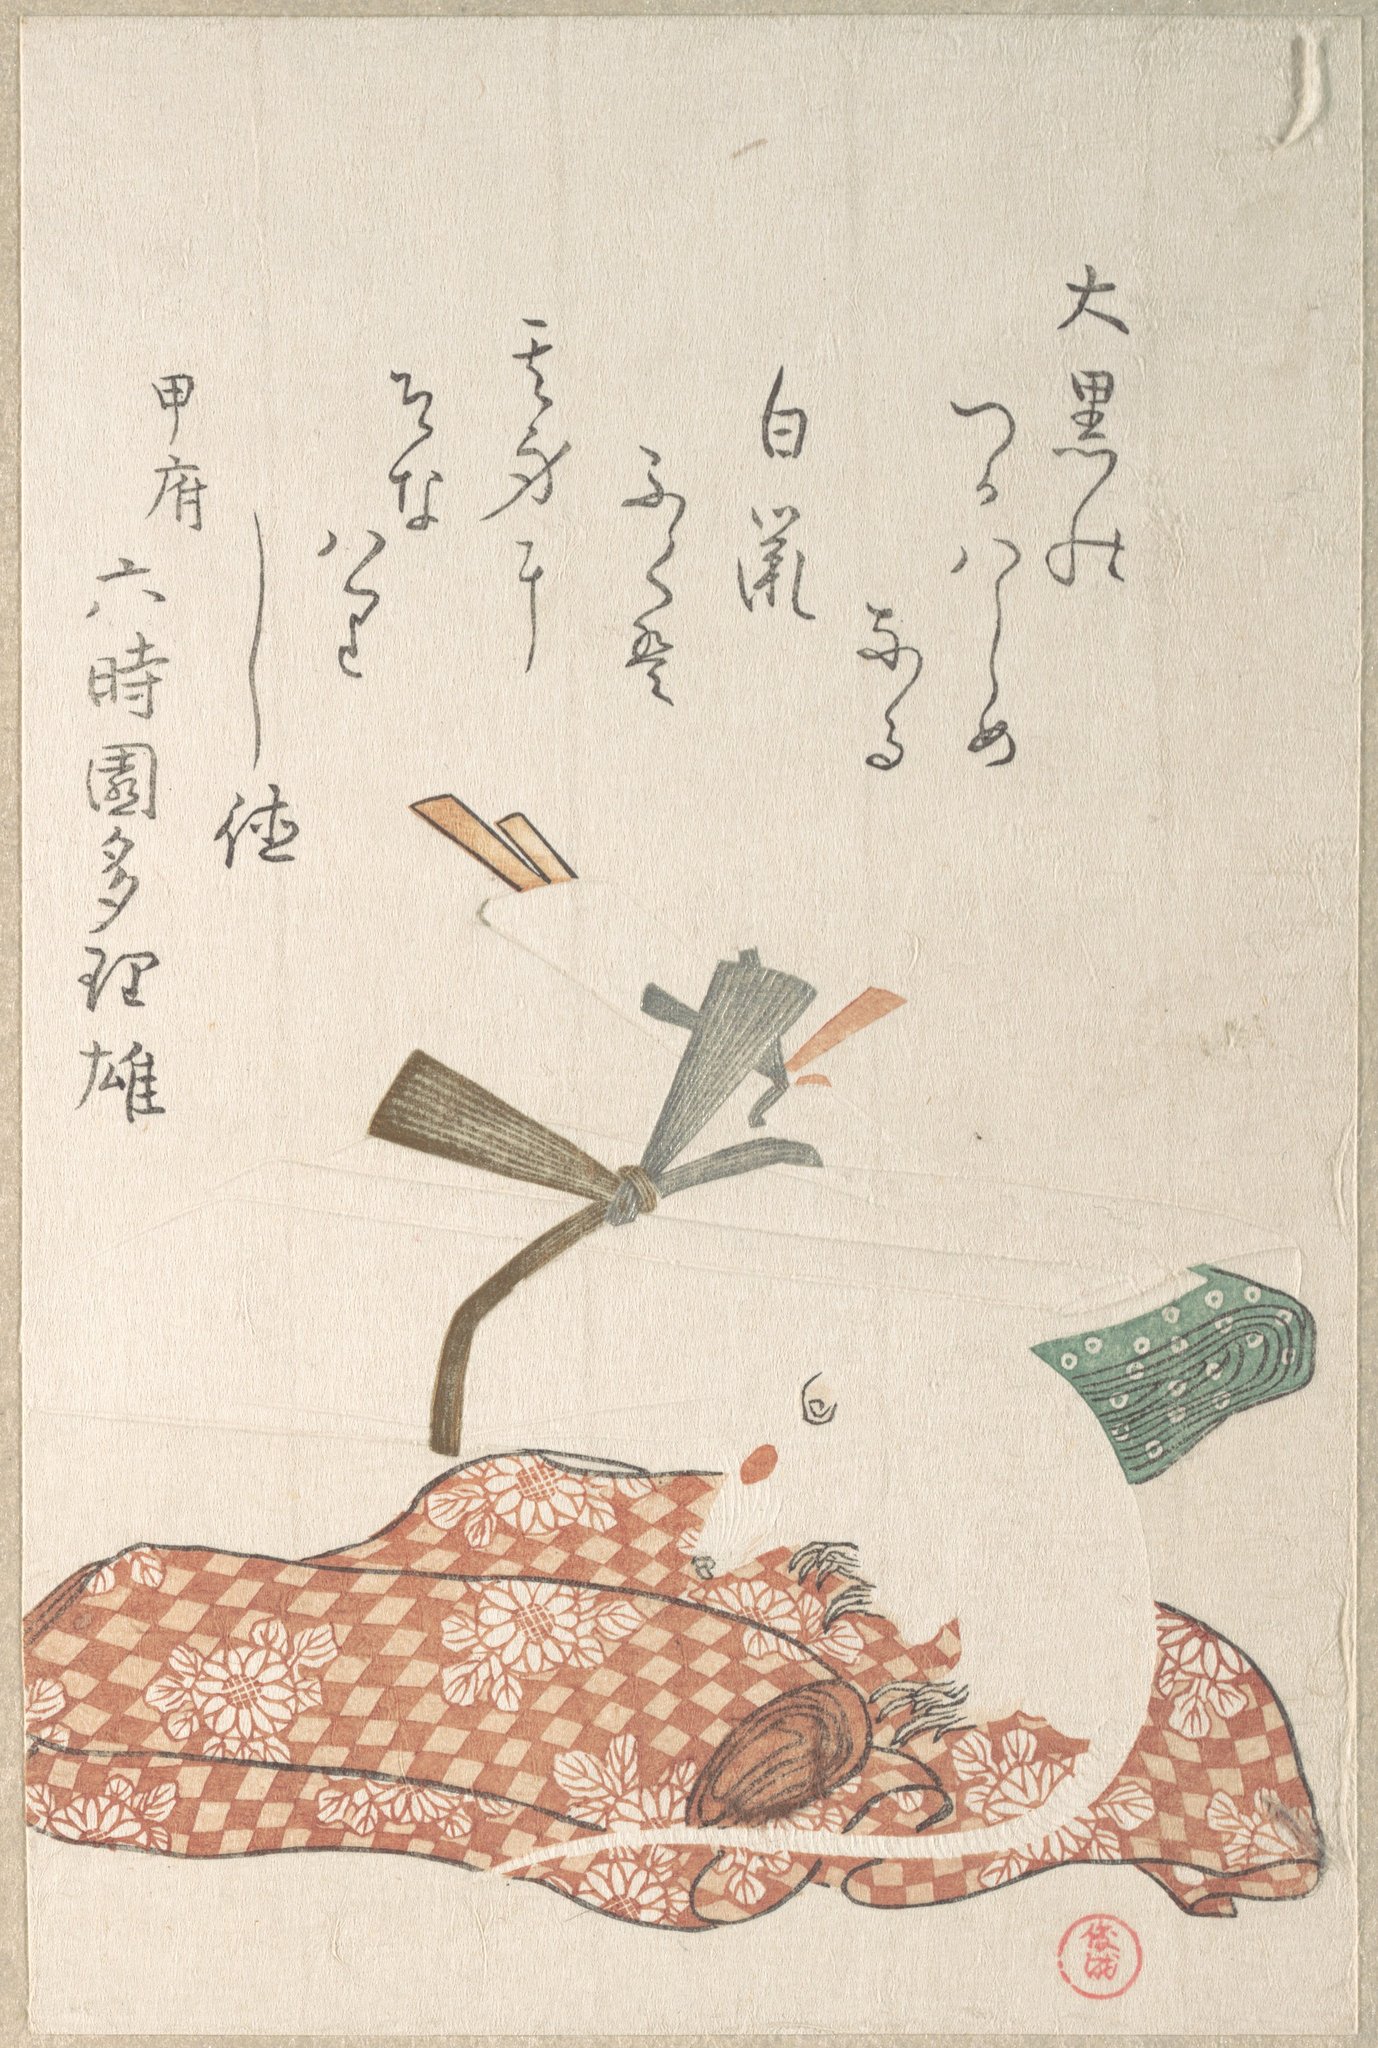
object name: woodblock print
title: White Rat and Bundles of Cloth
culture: japanese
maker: kubo shunman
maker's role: artist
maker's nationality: japanese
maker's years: 1757-1820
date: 1816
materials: ink, paper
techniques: surimono, woodblock print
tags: rats,textiles